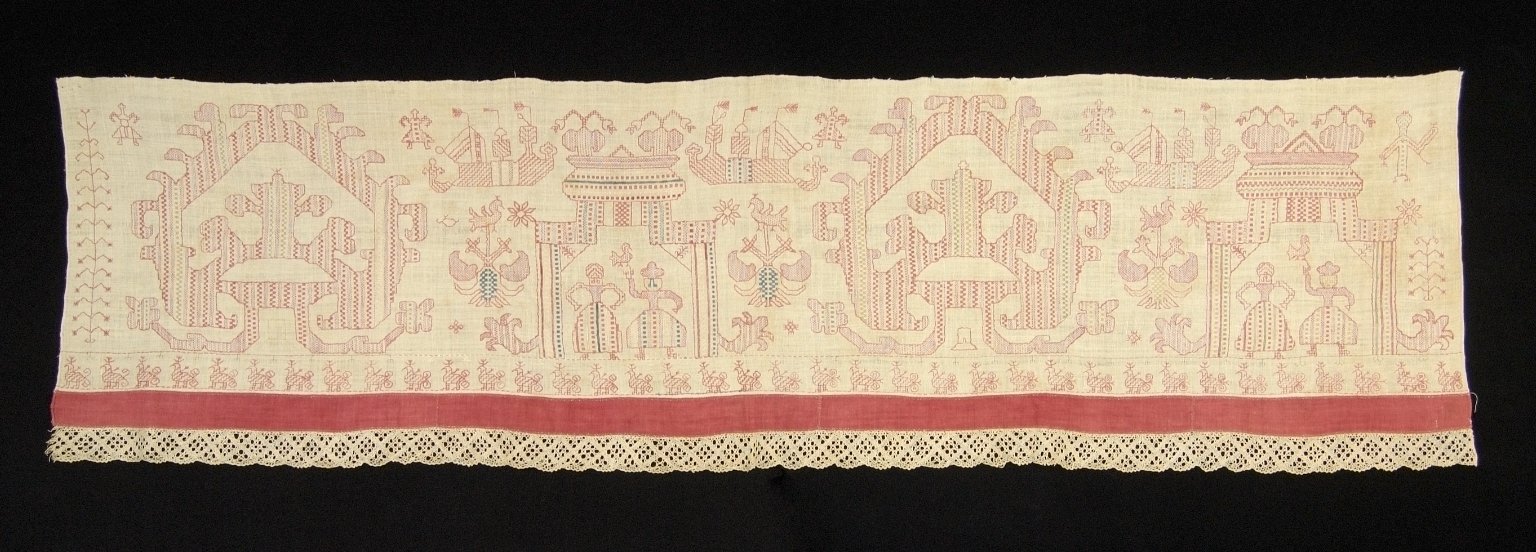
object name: border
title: Bed curtain border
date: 1800-1850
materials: cotton, linen, silk